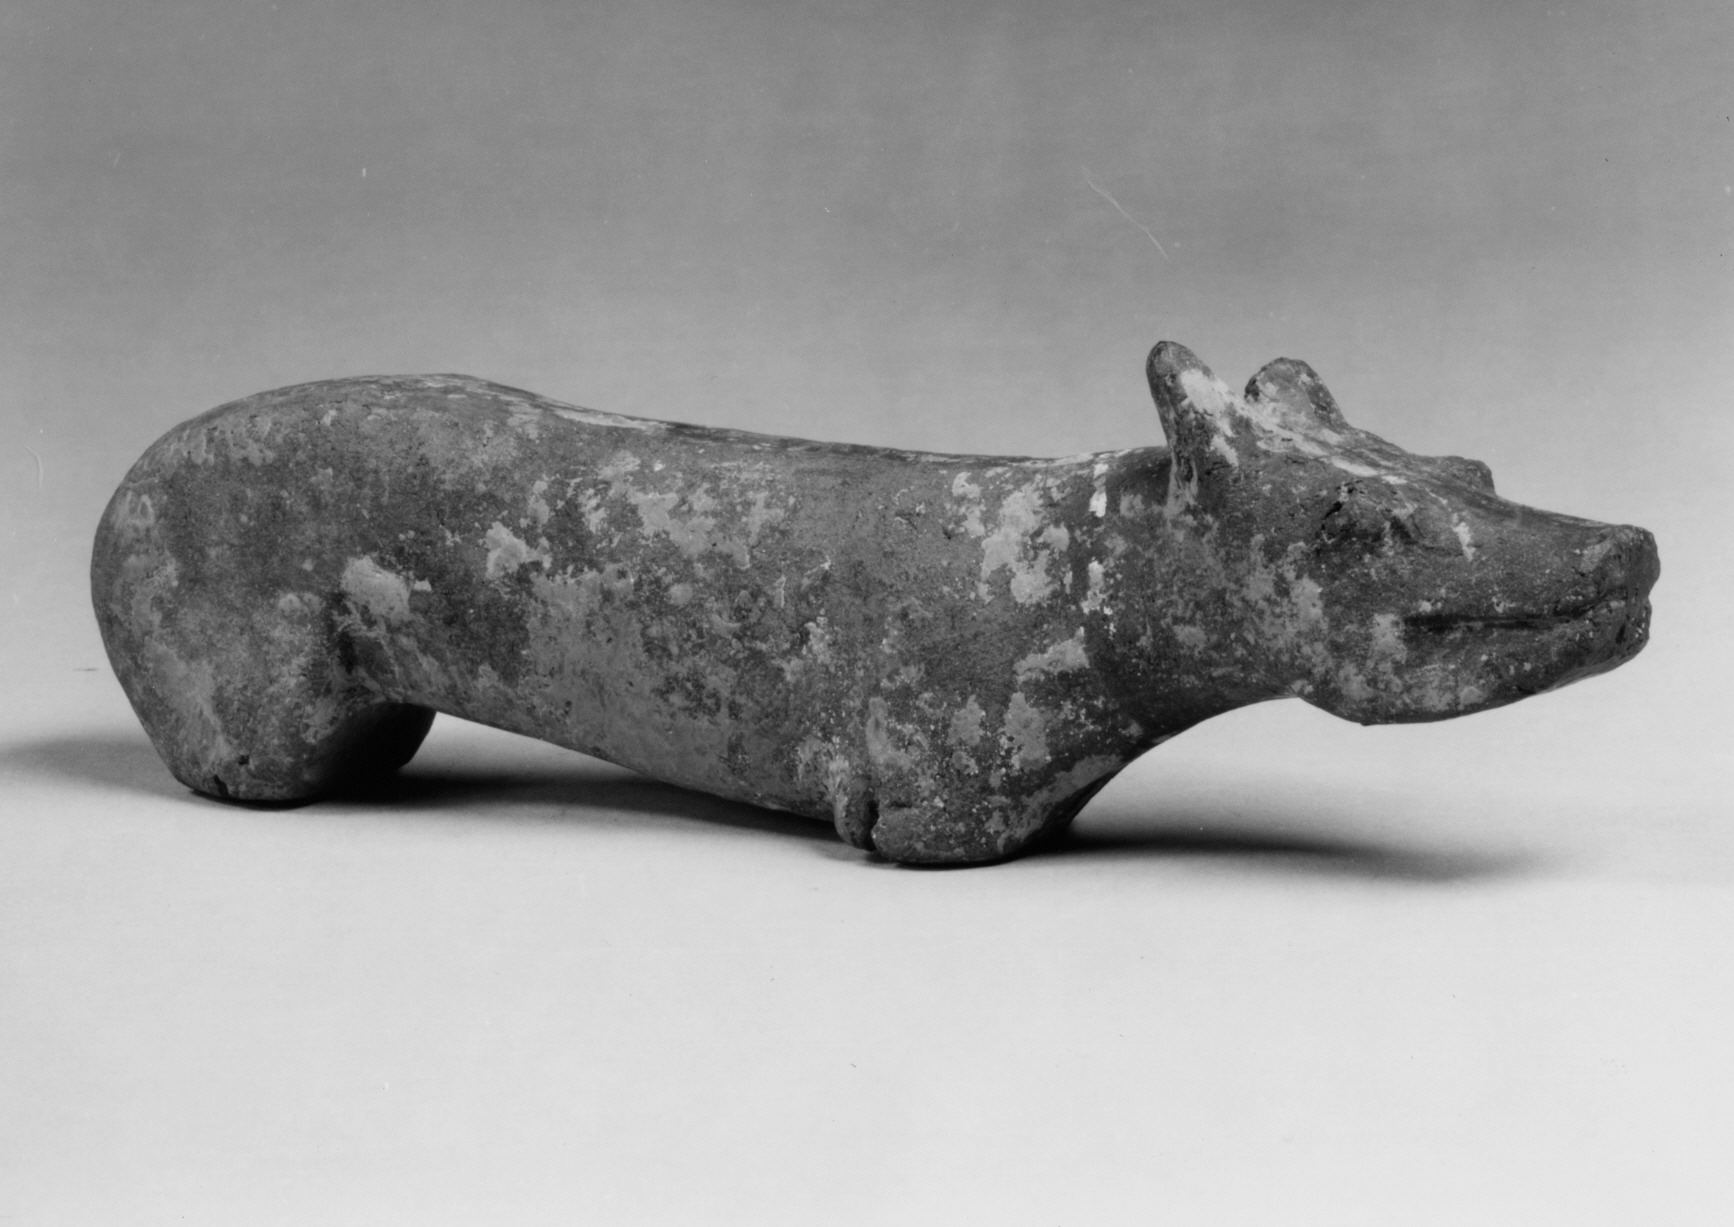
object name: tomb figure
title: Dog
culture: chinese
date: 401-600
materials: earthenware, pigment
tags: animals,tombs